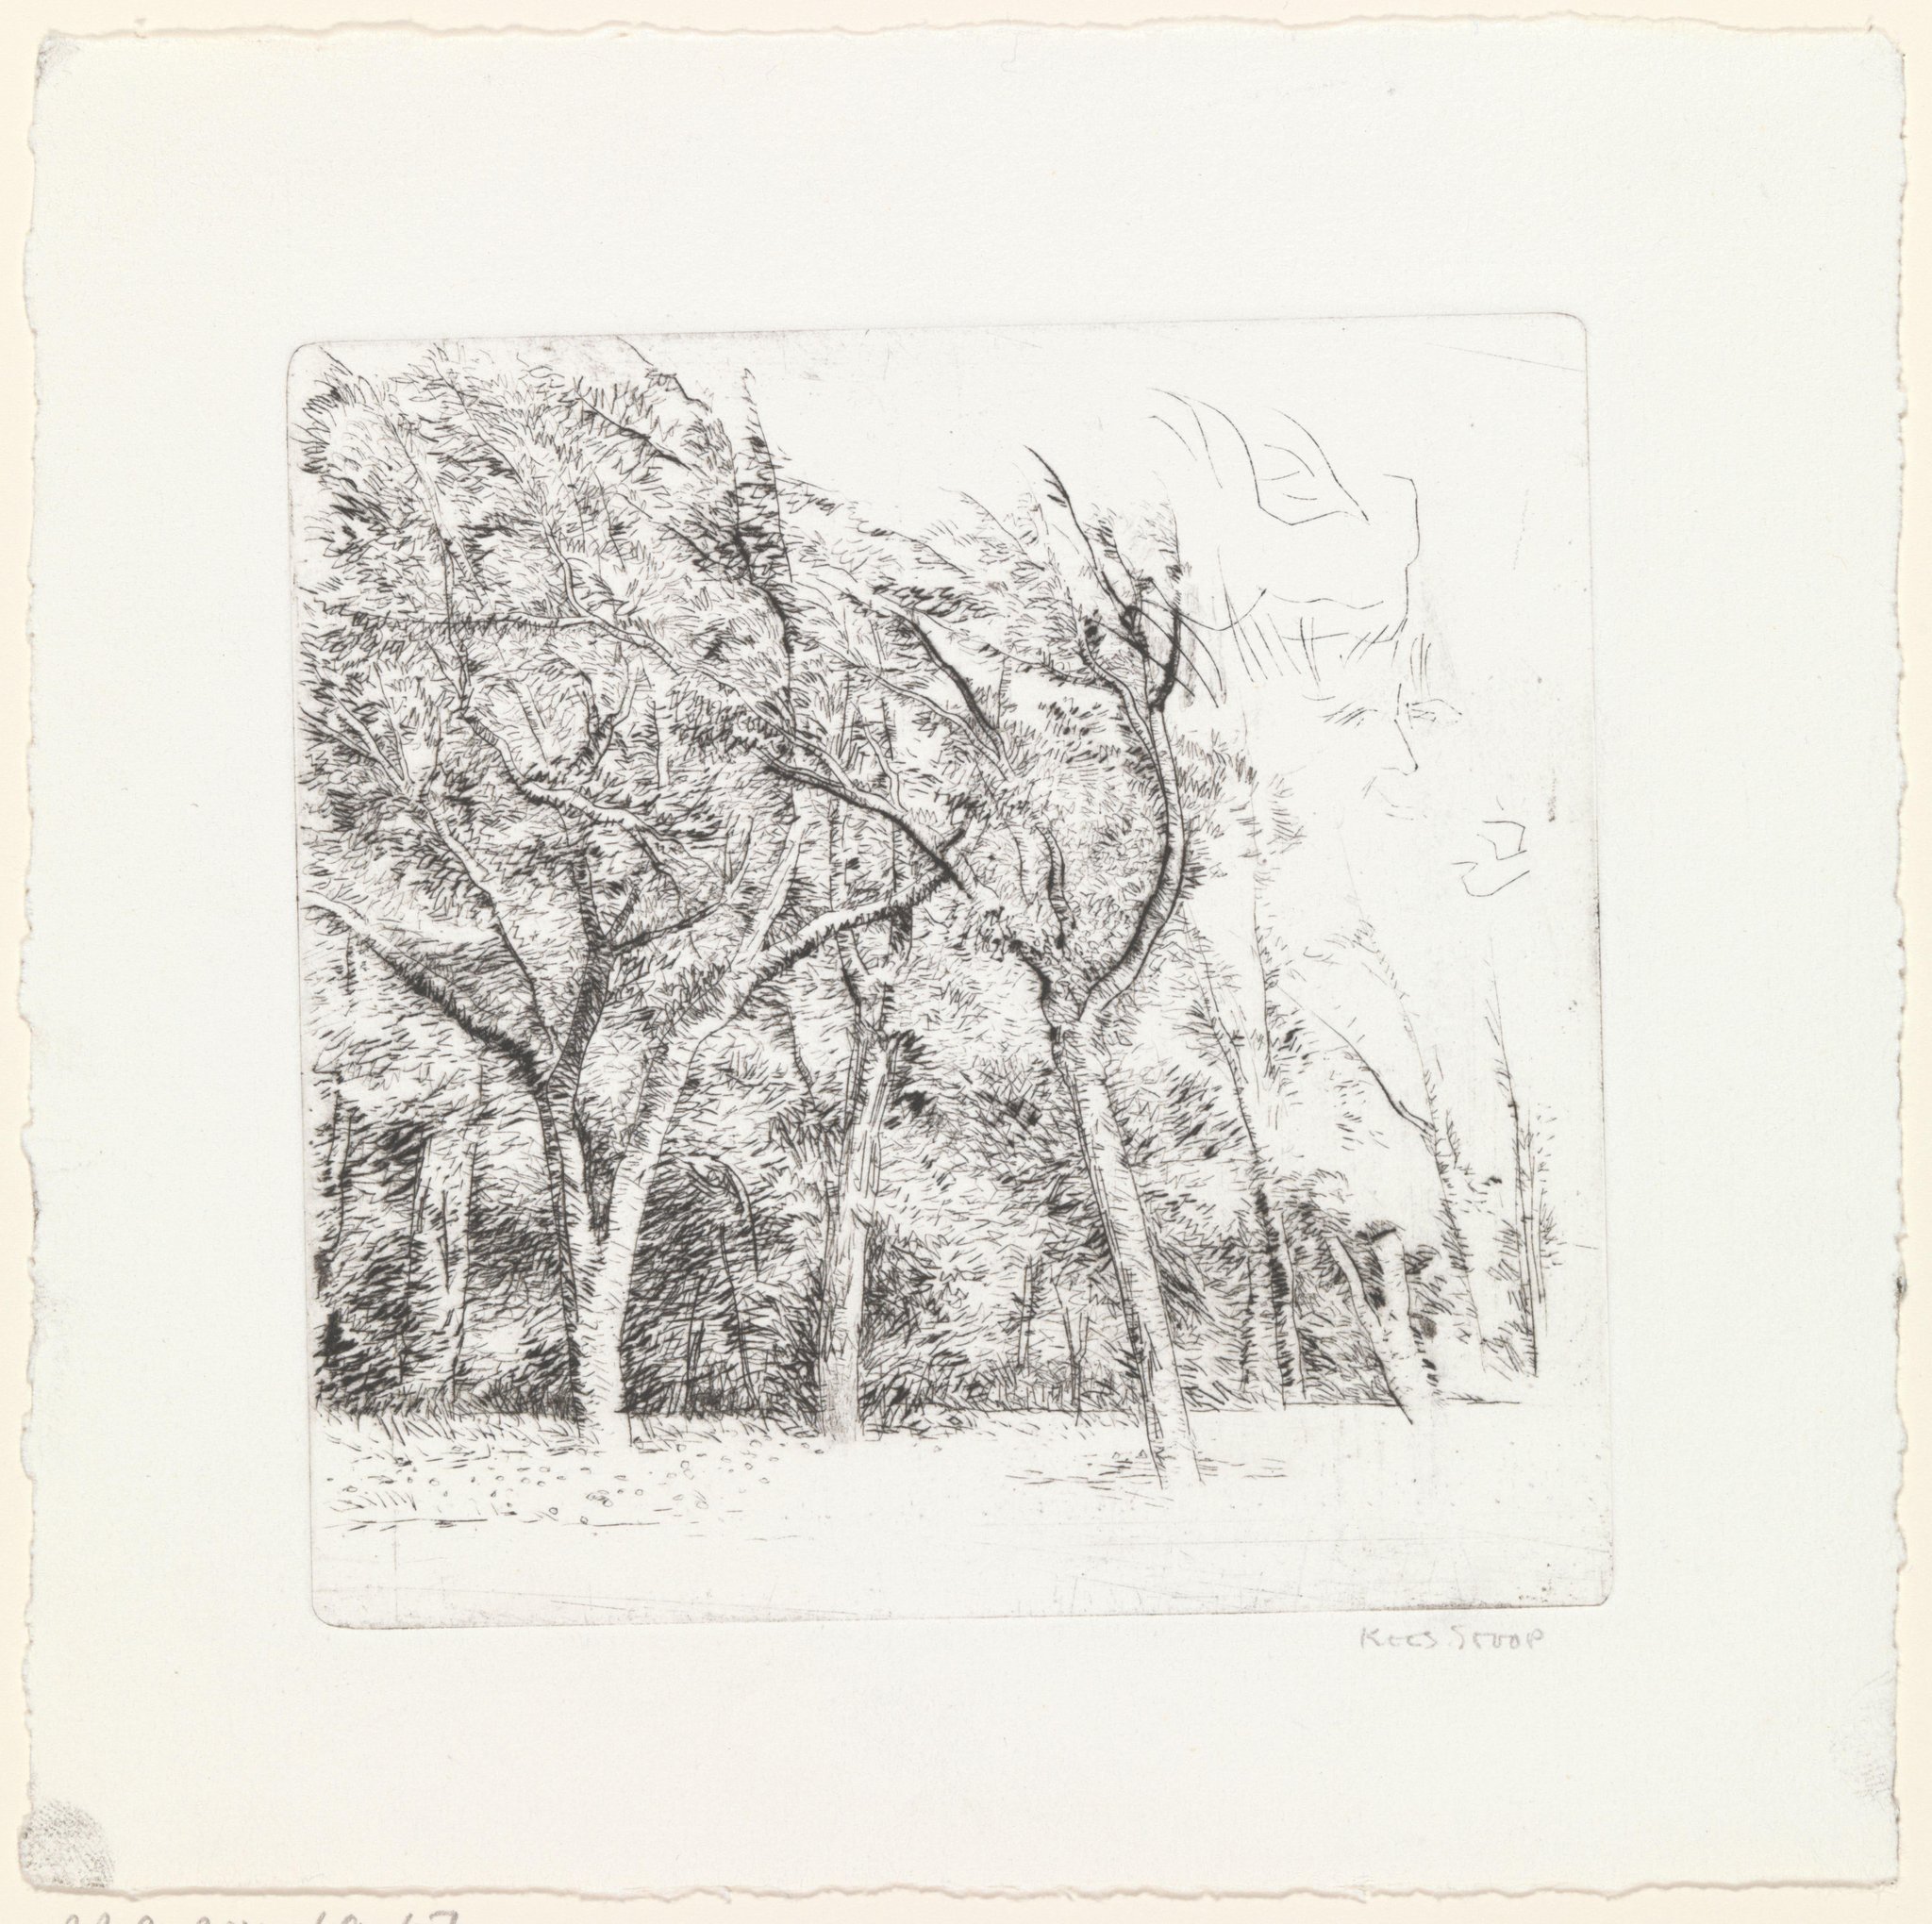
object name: print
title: Bomen en gezicht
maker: kees stoop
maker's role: draughtsman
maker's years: 1929-2019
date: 1944-1990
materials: paper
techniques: etching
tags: trees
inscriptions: signature: ‘KEES STOOP’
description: Groep bomen en in vage contouren, rechtsboven een gezicht.